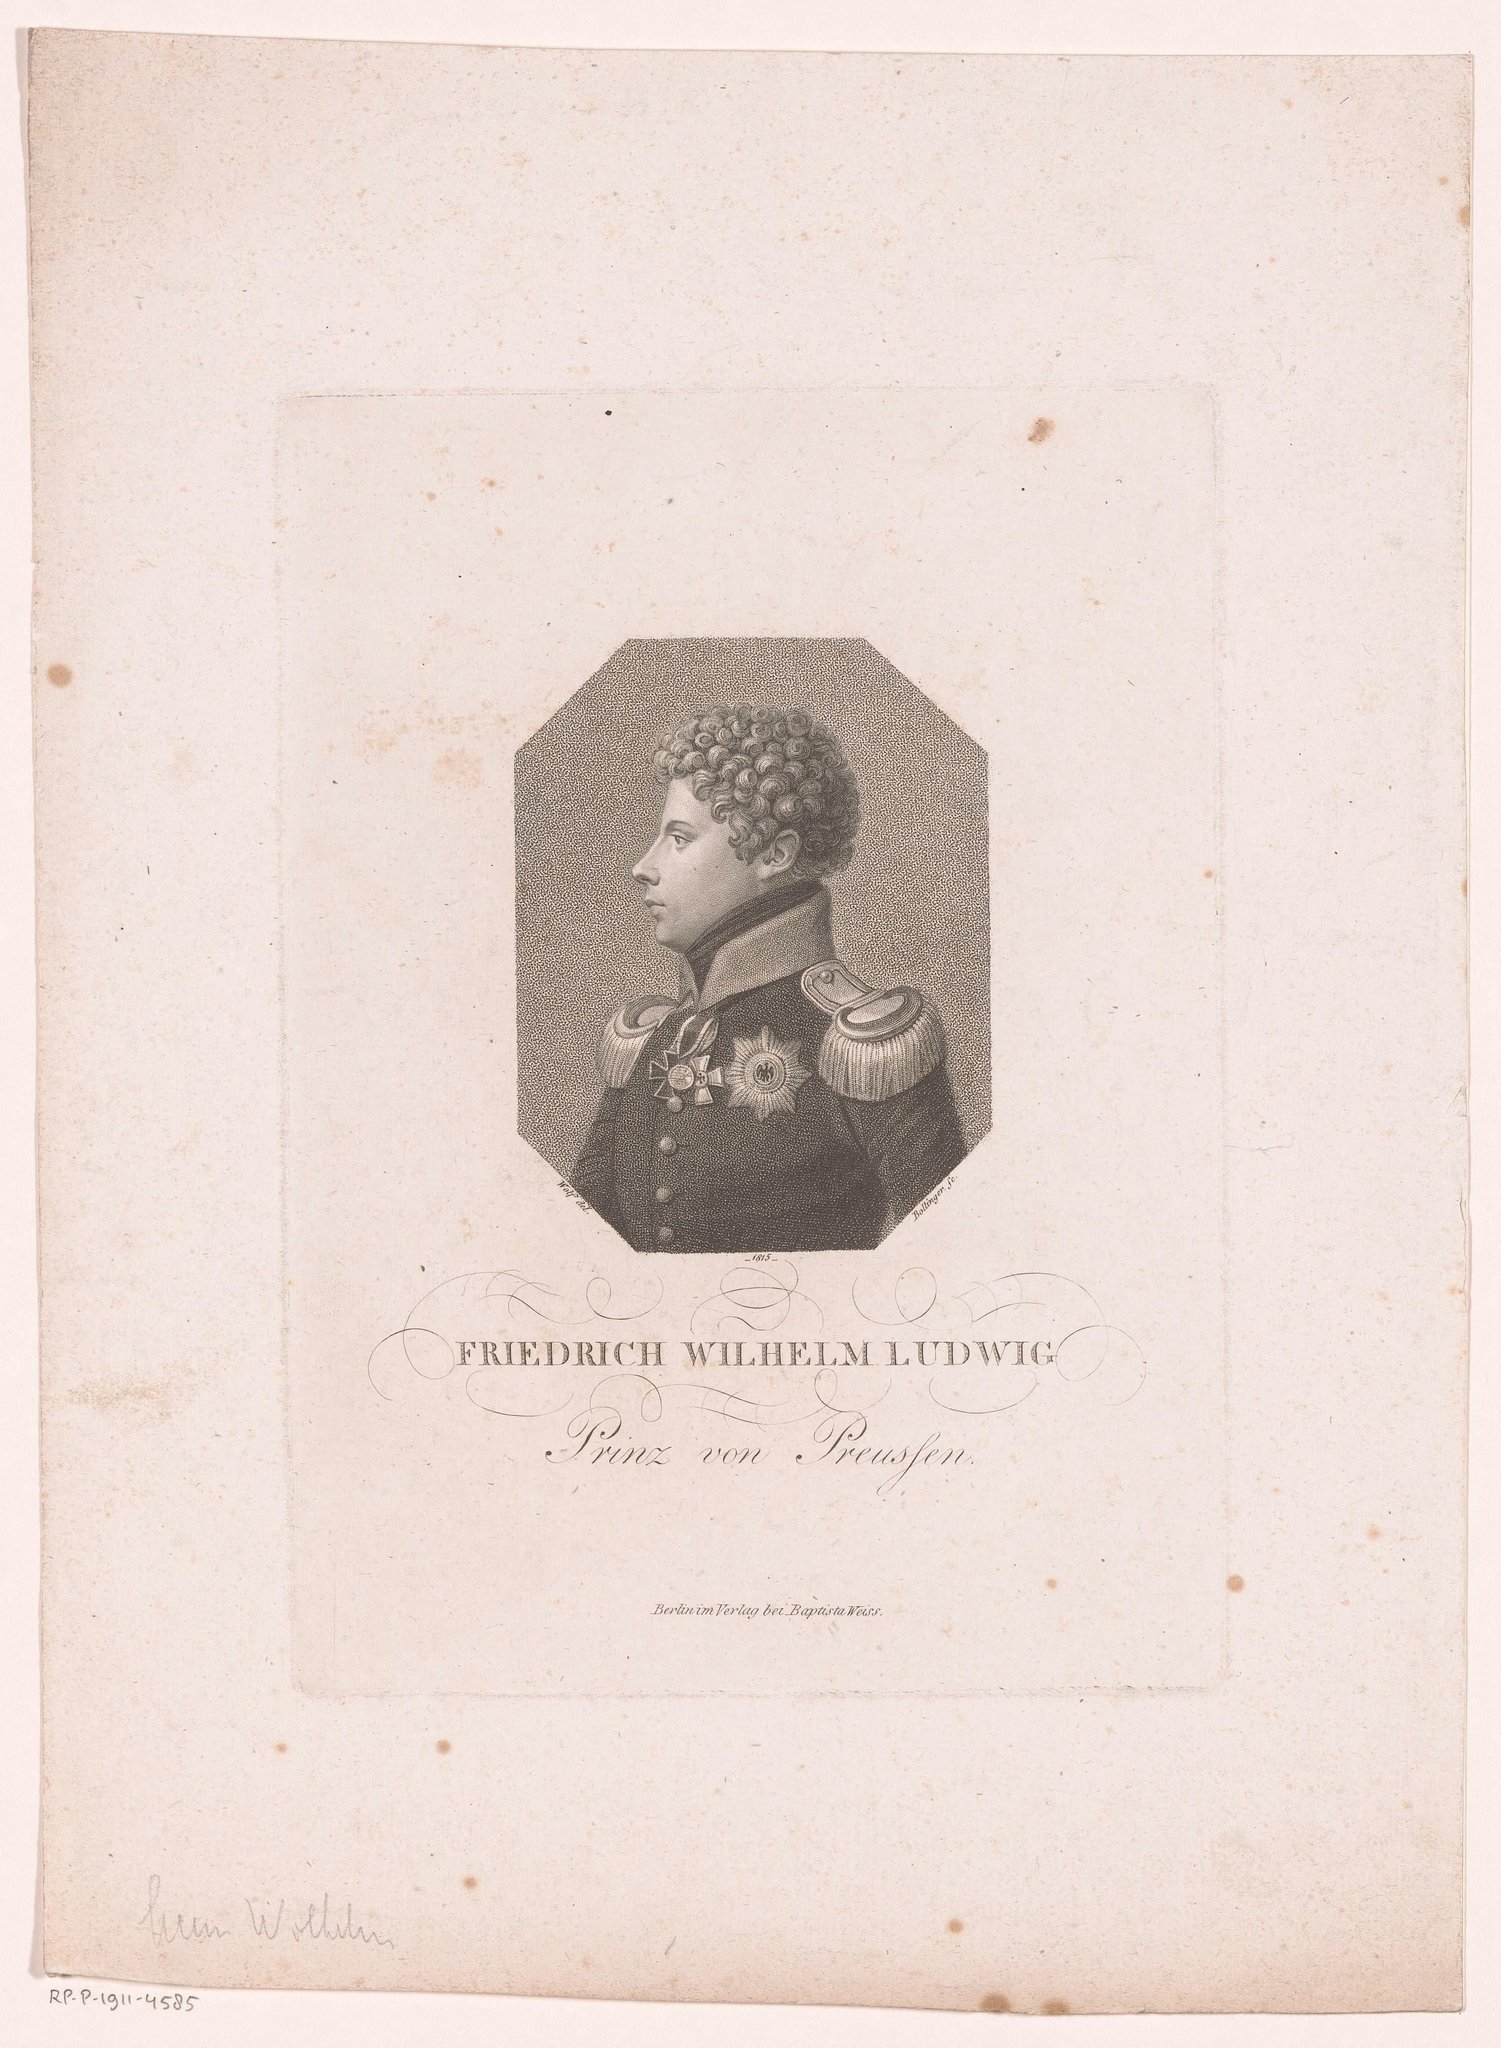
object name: print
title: Portret van Friedrich Wilhelm Ludwig van Pruisen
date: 1815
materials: paper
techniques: stippling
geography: berlin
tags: berlin, knighthood order (with name) - insignia of a knighthood order, e.g.: badge, chain (with name of order), knighthood order, historical persons, (military) uniforms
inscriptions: collector's mark: Lugt 2228